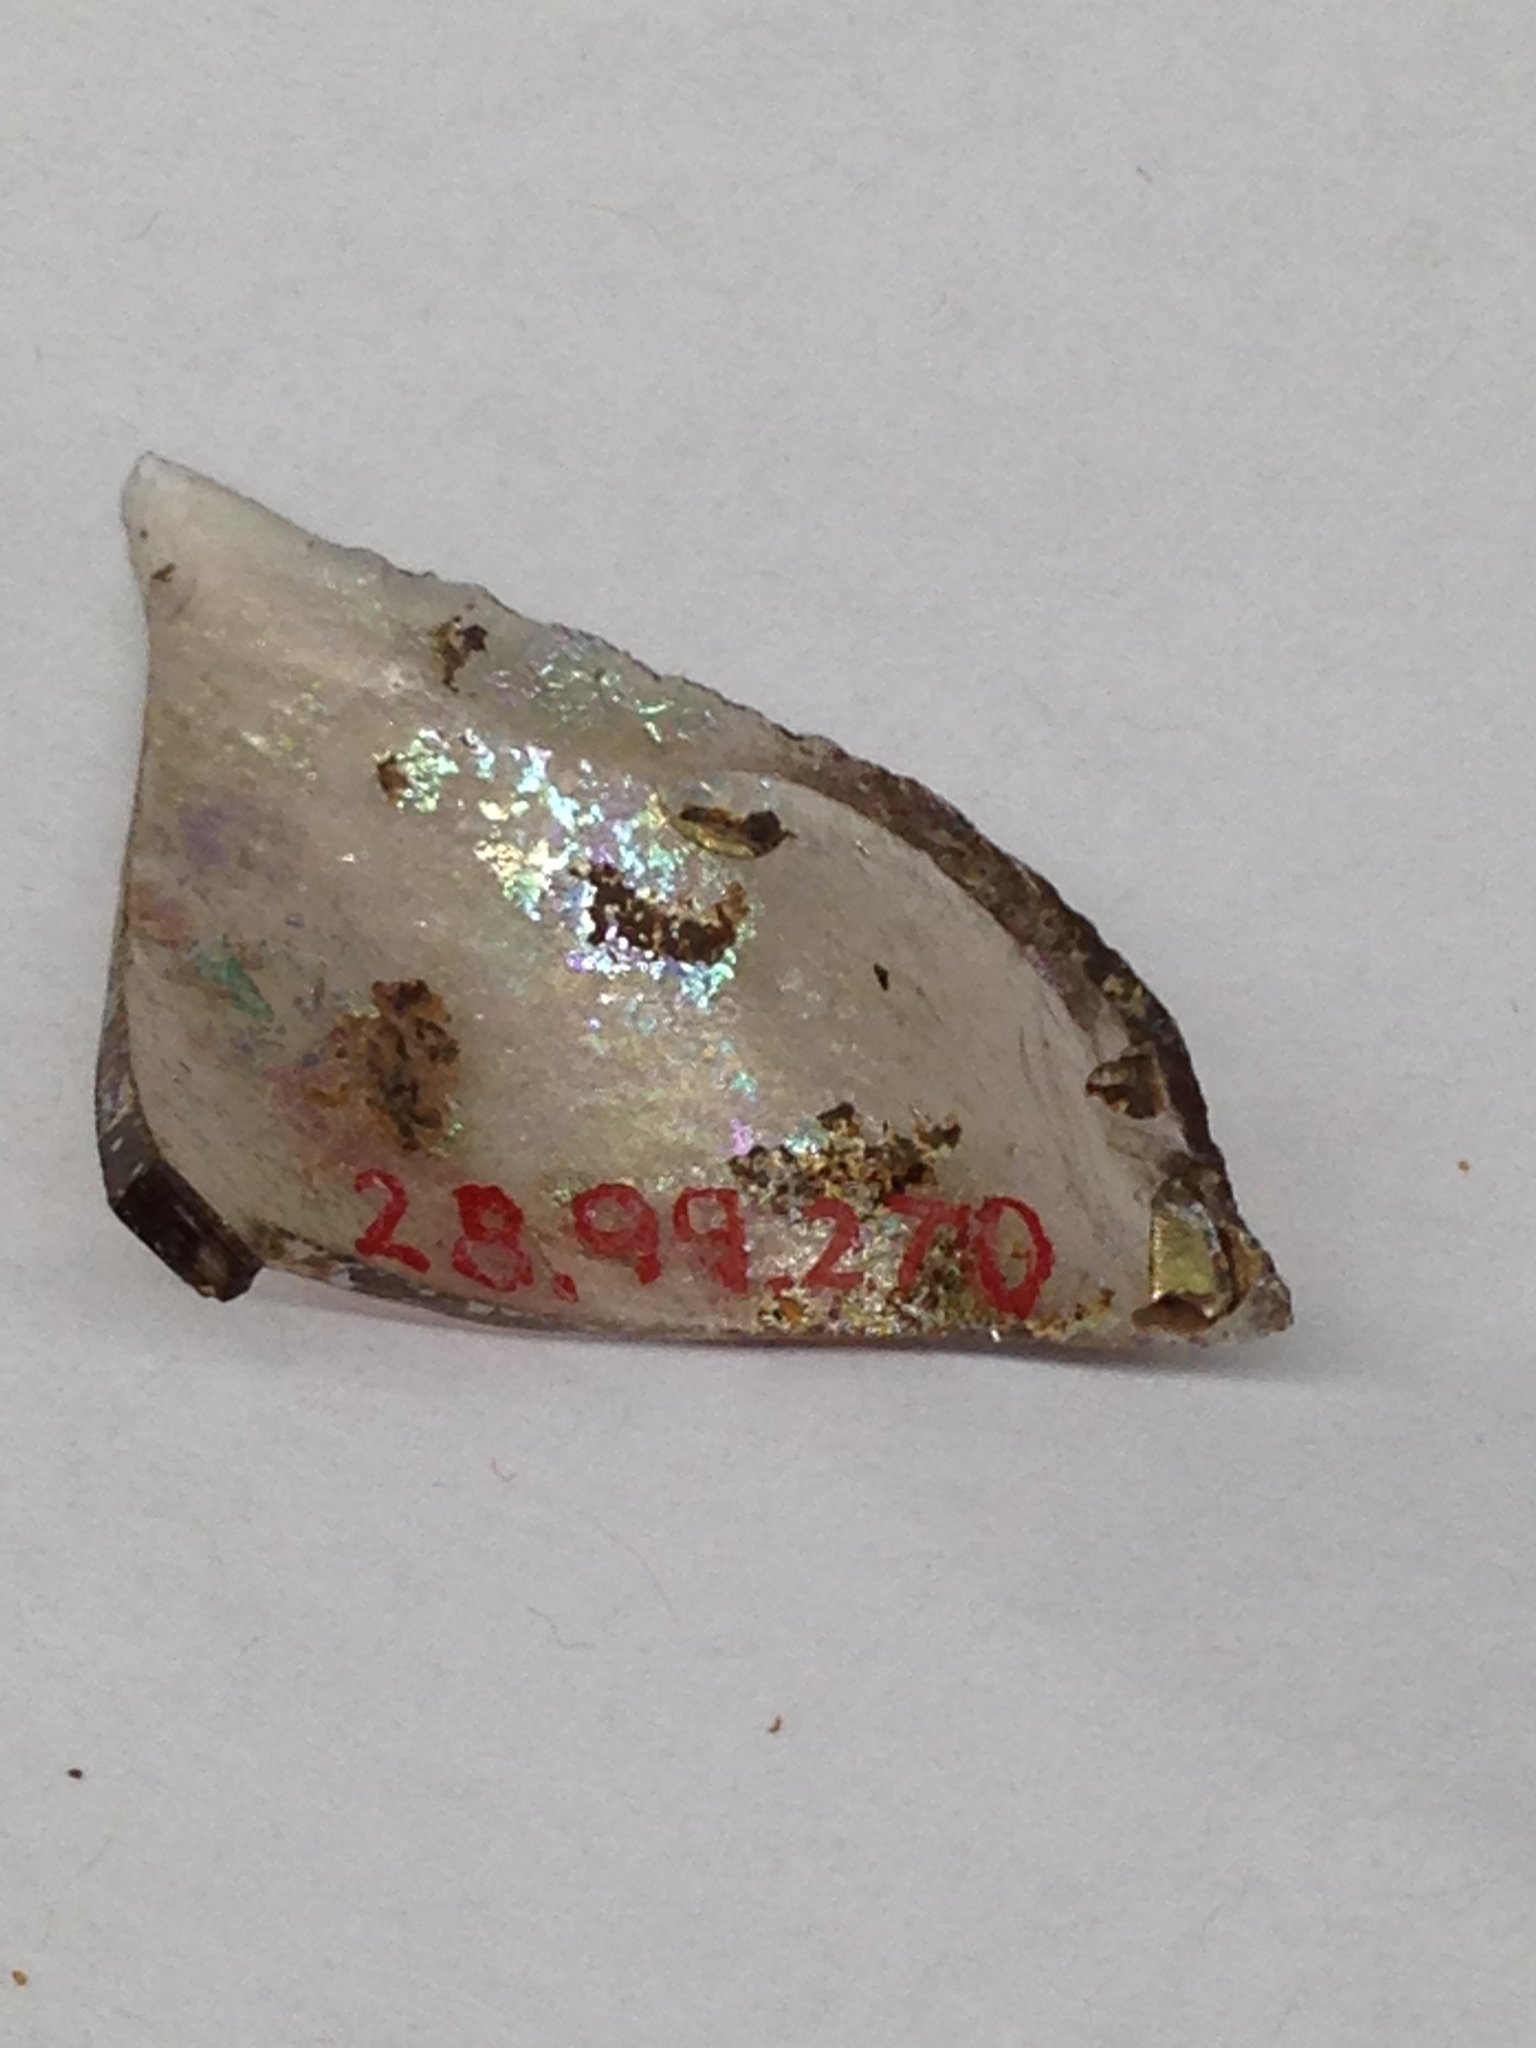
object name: fragment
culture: european or middle eastern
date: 1150-1250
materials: ceramic, glass